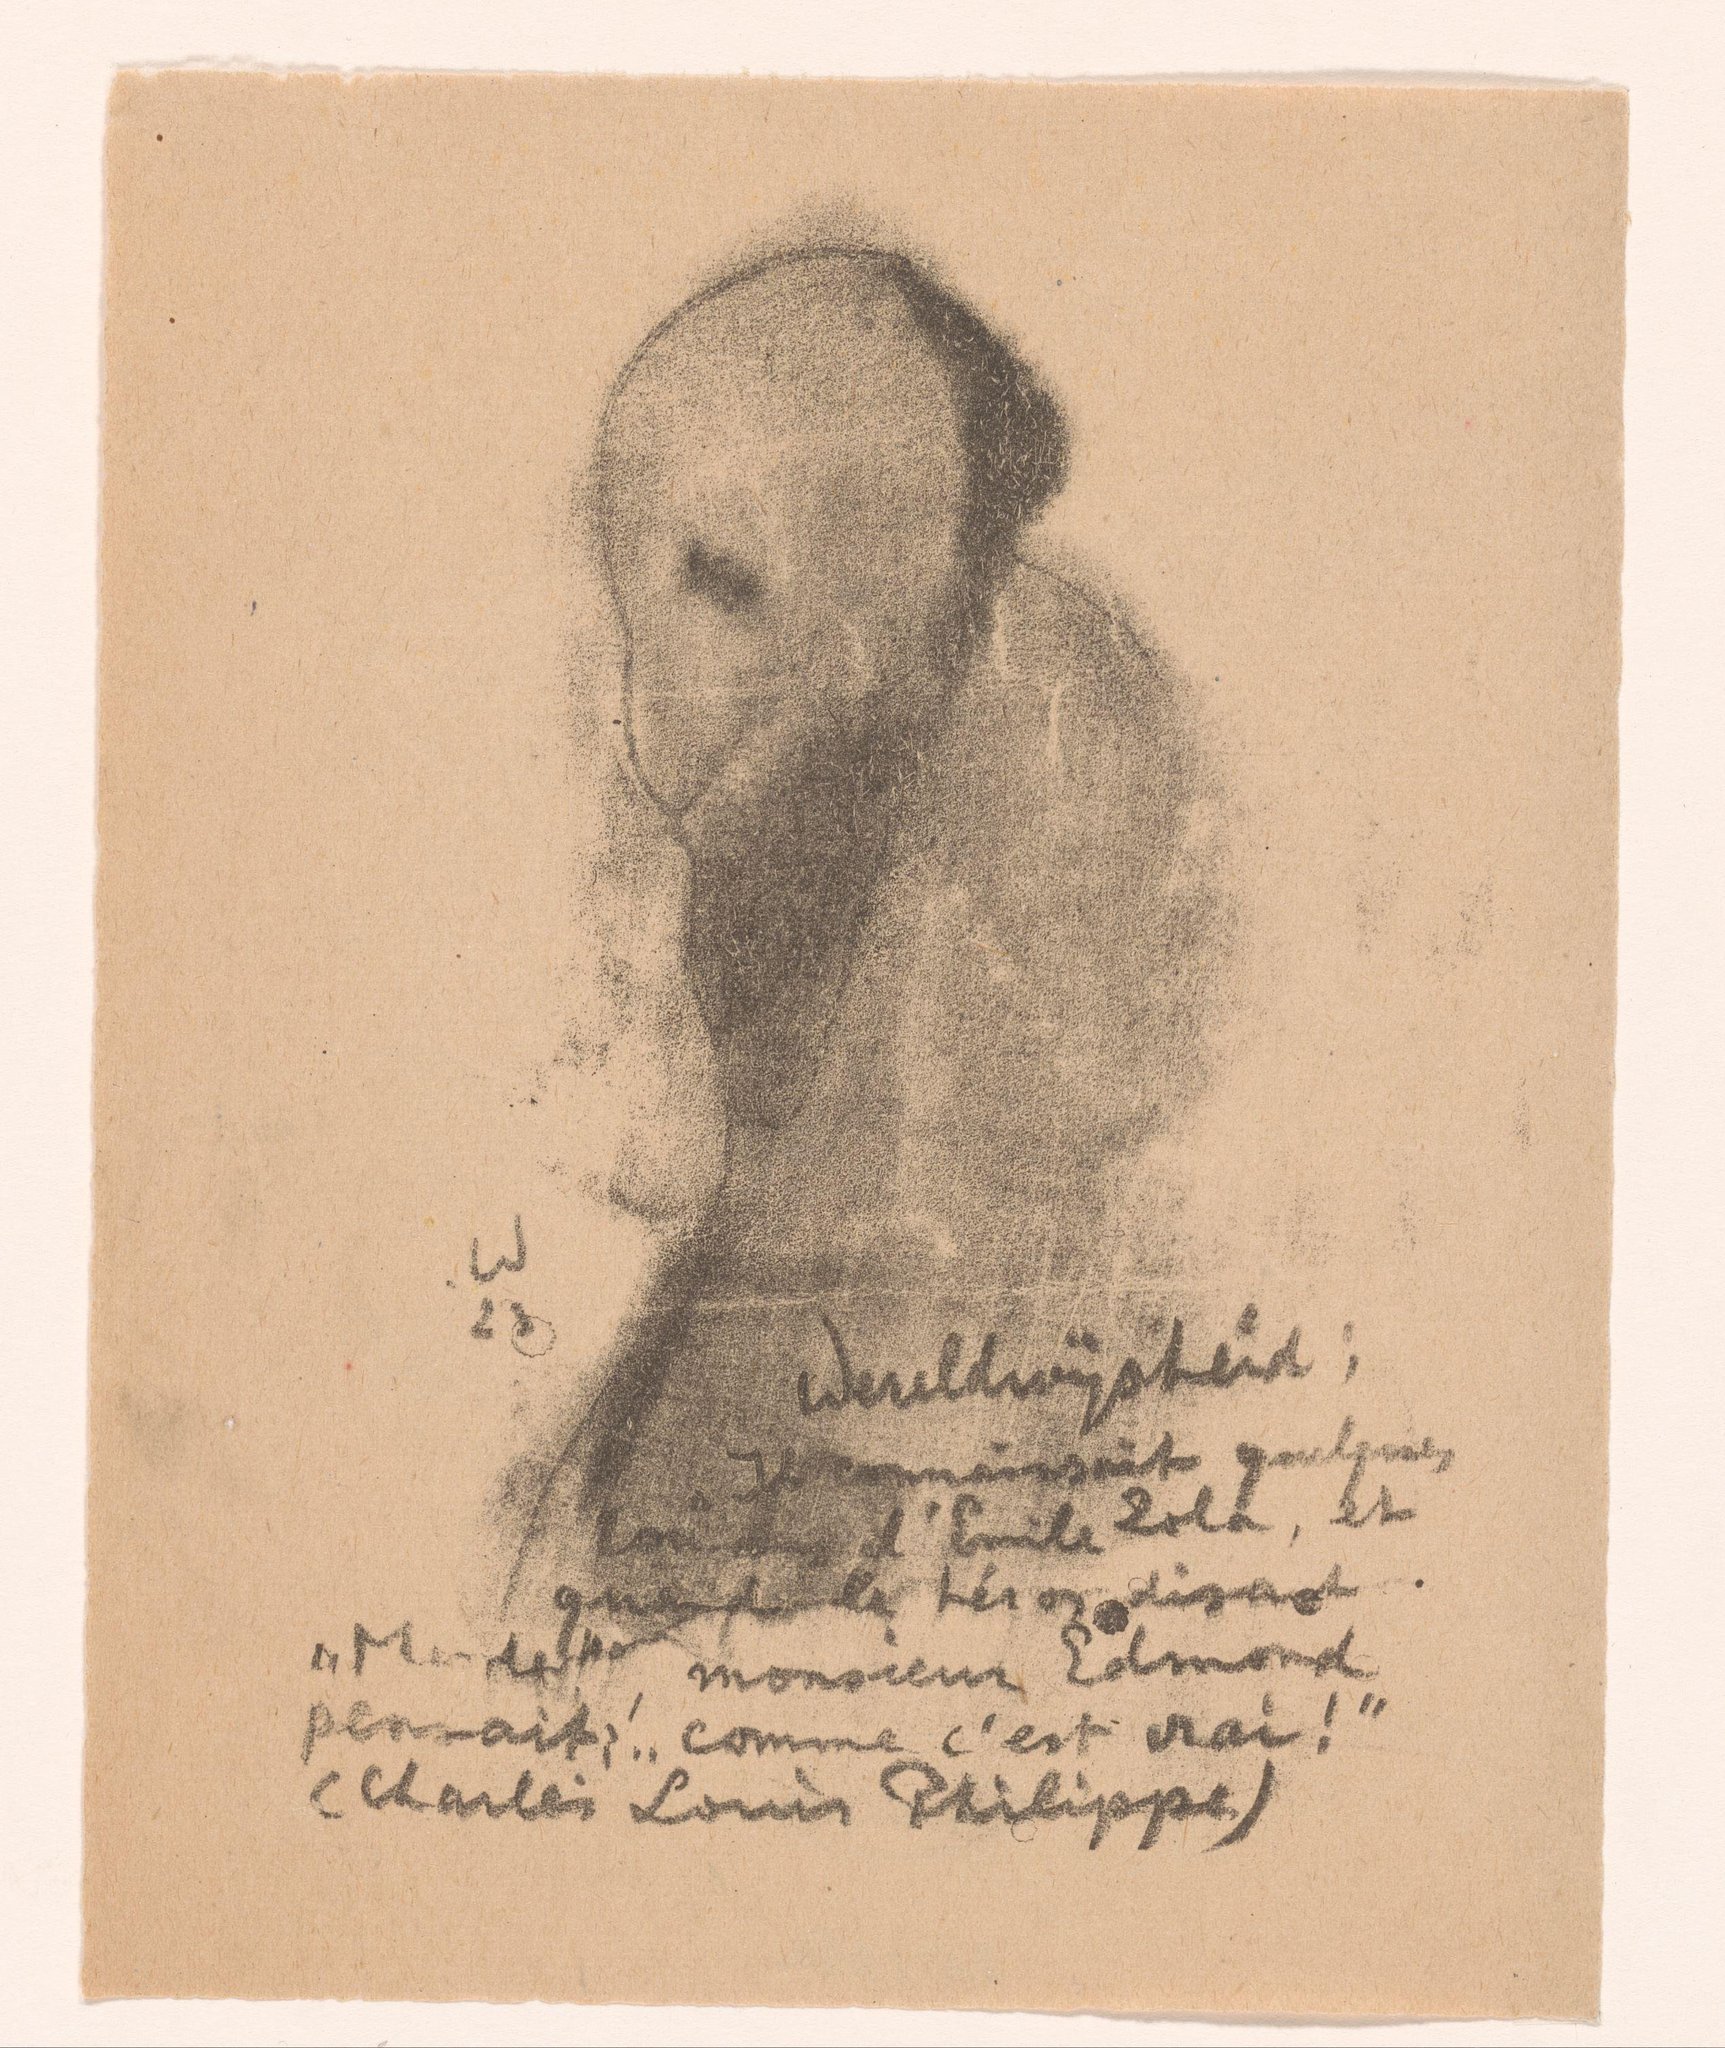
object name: print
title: Geabstraheerde figuur met baard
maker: erich wichmann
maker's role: print maker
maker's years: 1890-1929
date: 1923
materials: paper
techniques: lithograph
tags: caricatures (human types)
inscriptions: collector's mark: Lugt 2228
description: Onderaan de tekst: 'Wereldwijsheid: "Il connaissait quelques (...) Charles Louis Philipppe)'.